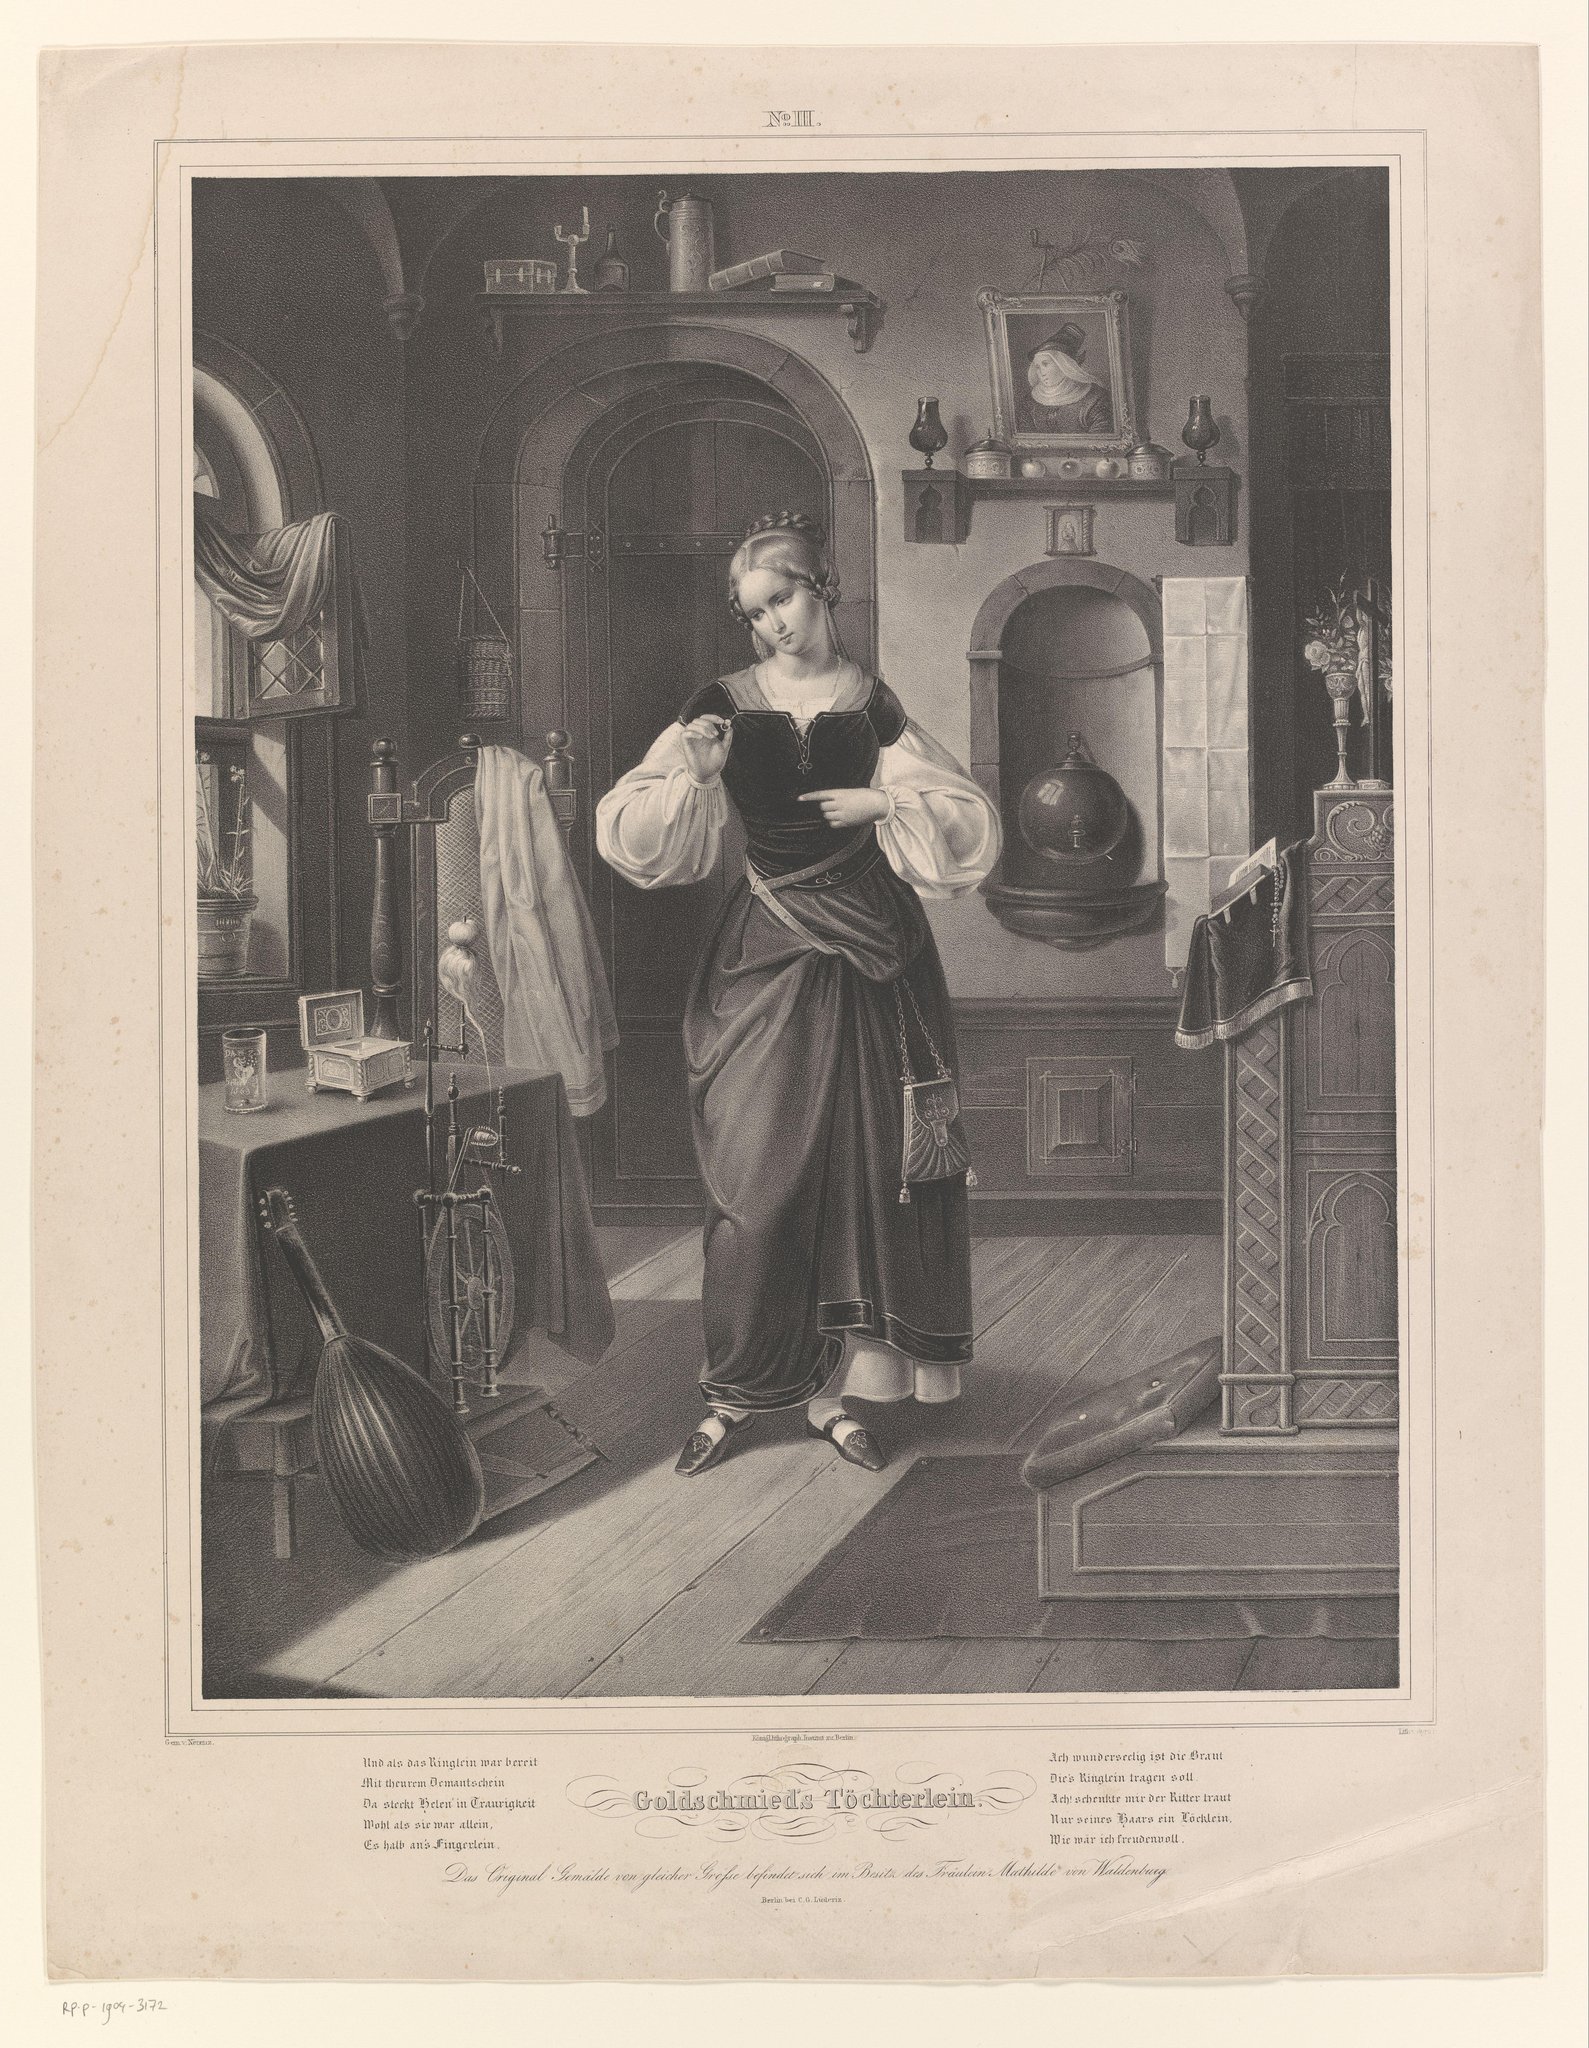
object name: print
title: Dochter van de goudsmid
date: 1818-1837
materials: paper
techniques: lithograph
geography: berlin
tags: adult woman, interior of the house, ring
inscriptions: check stamp: Lugt 4519, collector's mark: Lugt 2228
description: Voorstelling uit het werk 'Goldschmieds Töchterlein' van Ludwig Uhland.